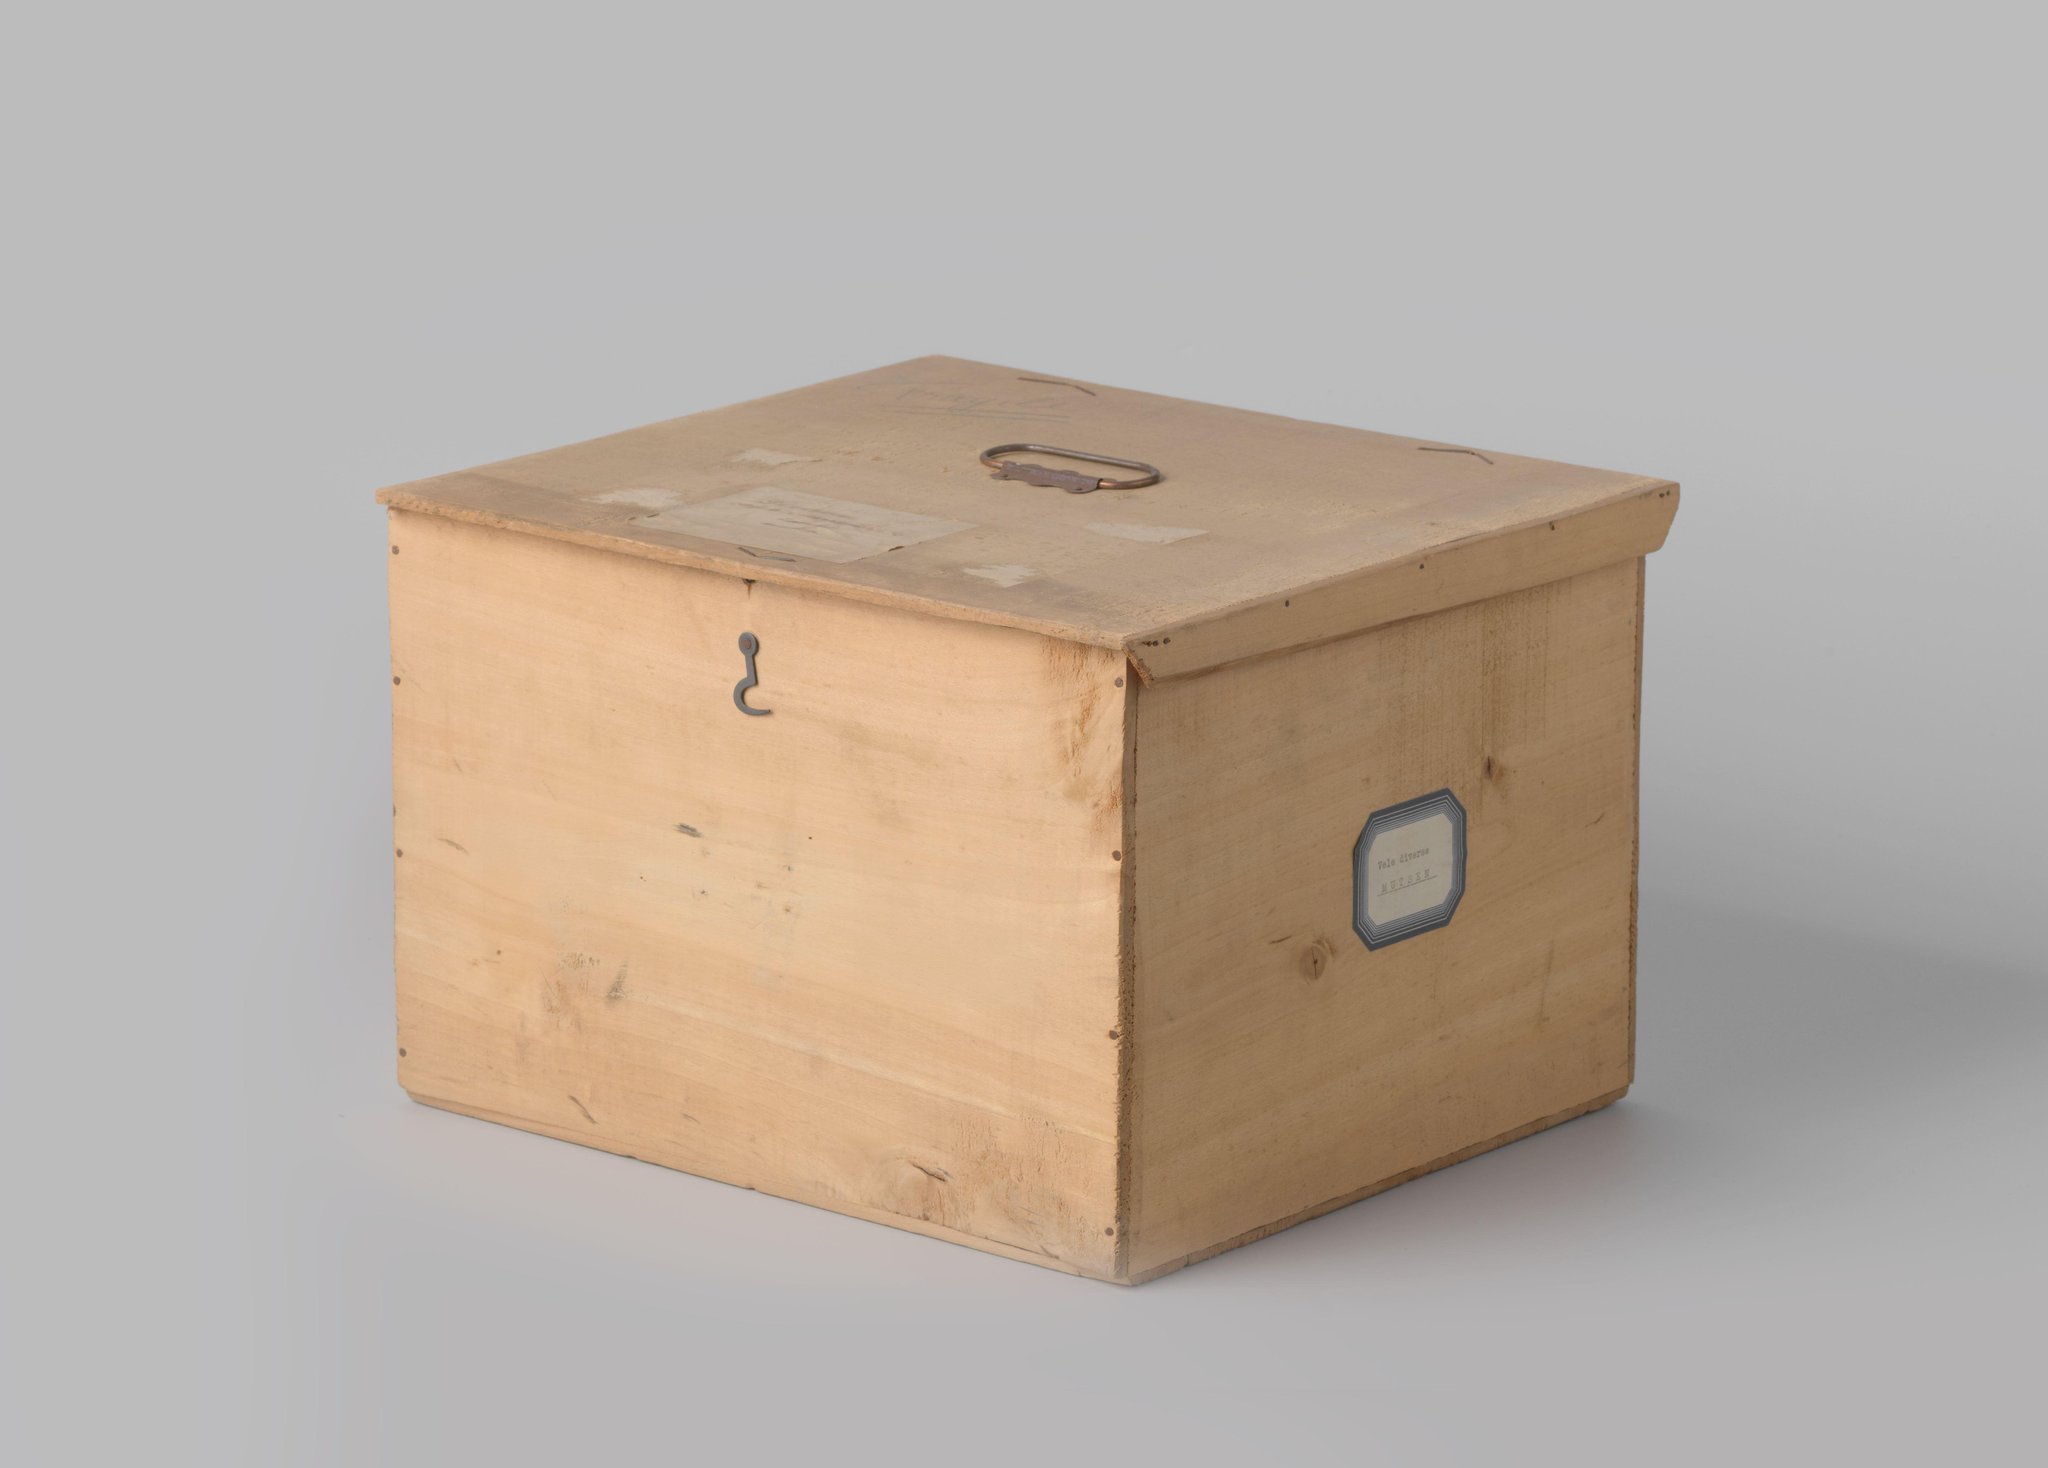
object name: box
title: Doos of kist met deksel van hout, van binnen beplakt met wit papier met blauw bloemmotief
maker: Anonymous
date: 1880-1965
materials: metal, paper, wood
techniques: woodworking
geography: western europe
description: Doos of kist met deksel van hout, van binnen beplakt met wit papier met blauw bloemmotief. De deksel is aan de doos bevestigd.